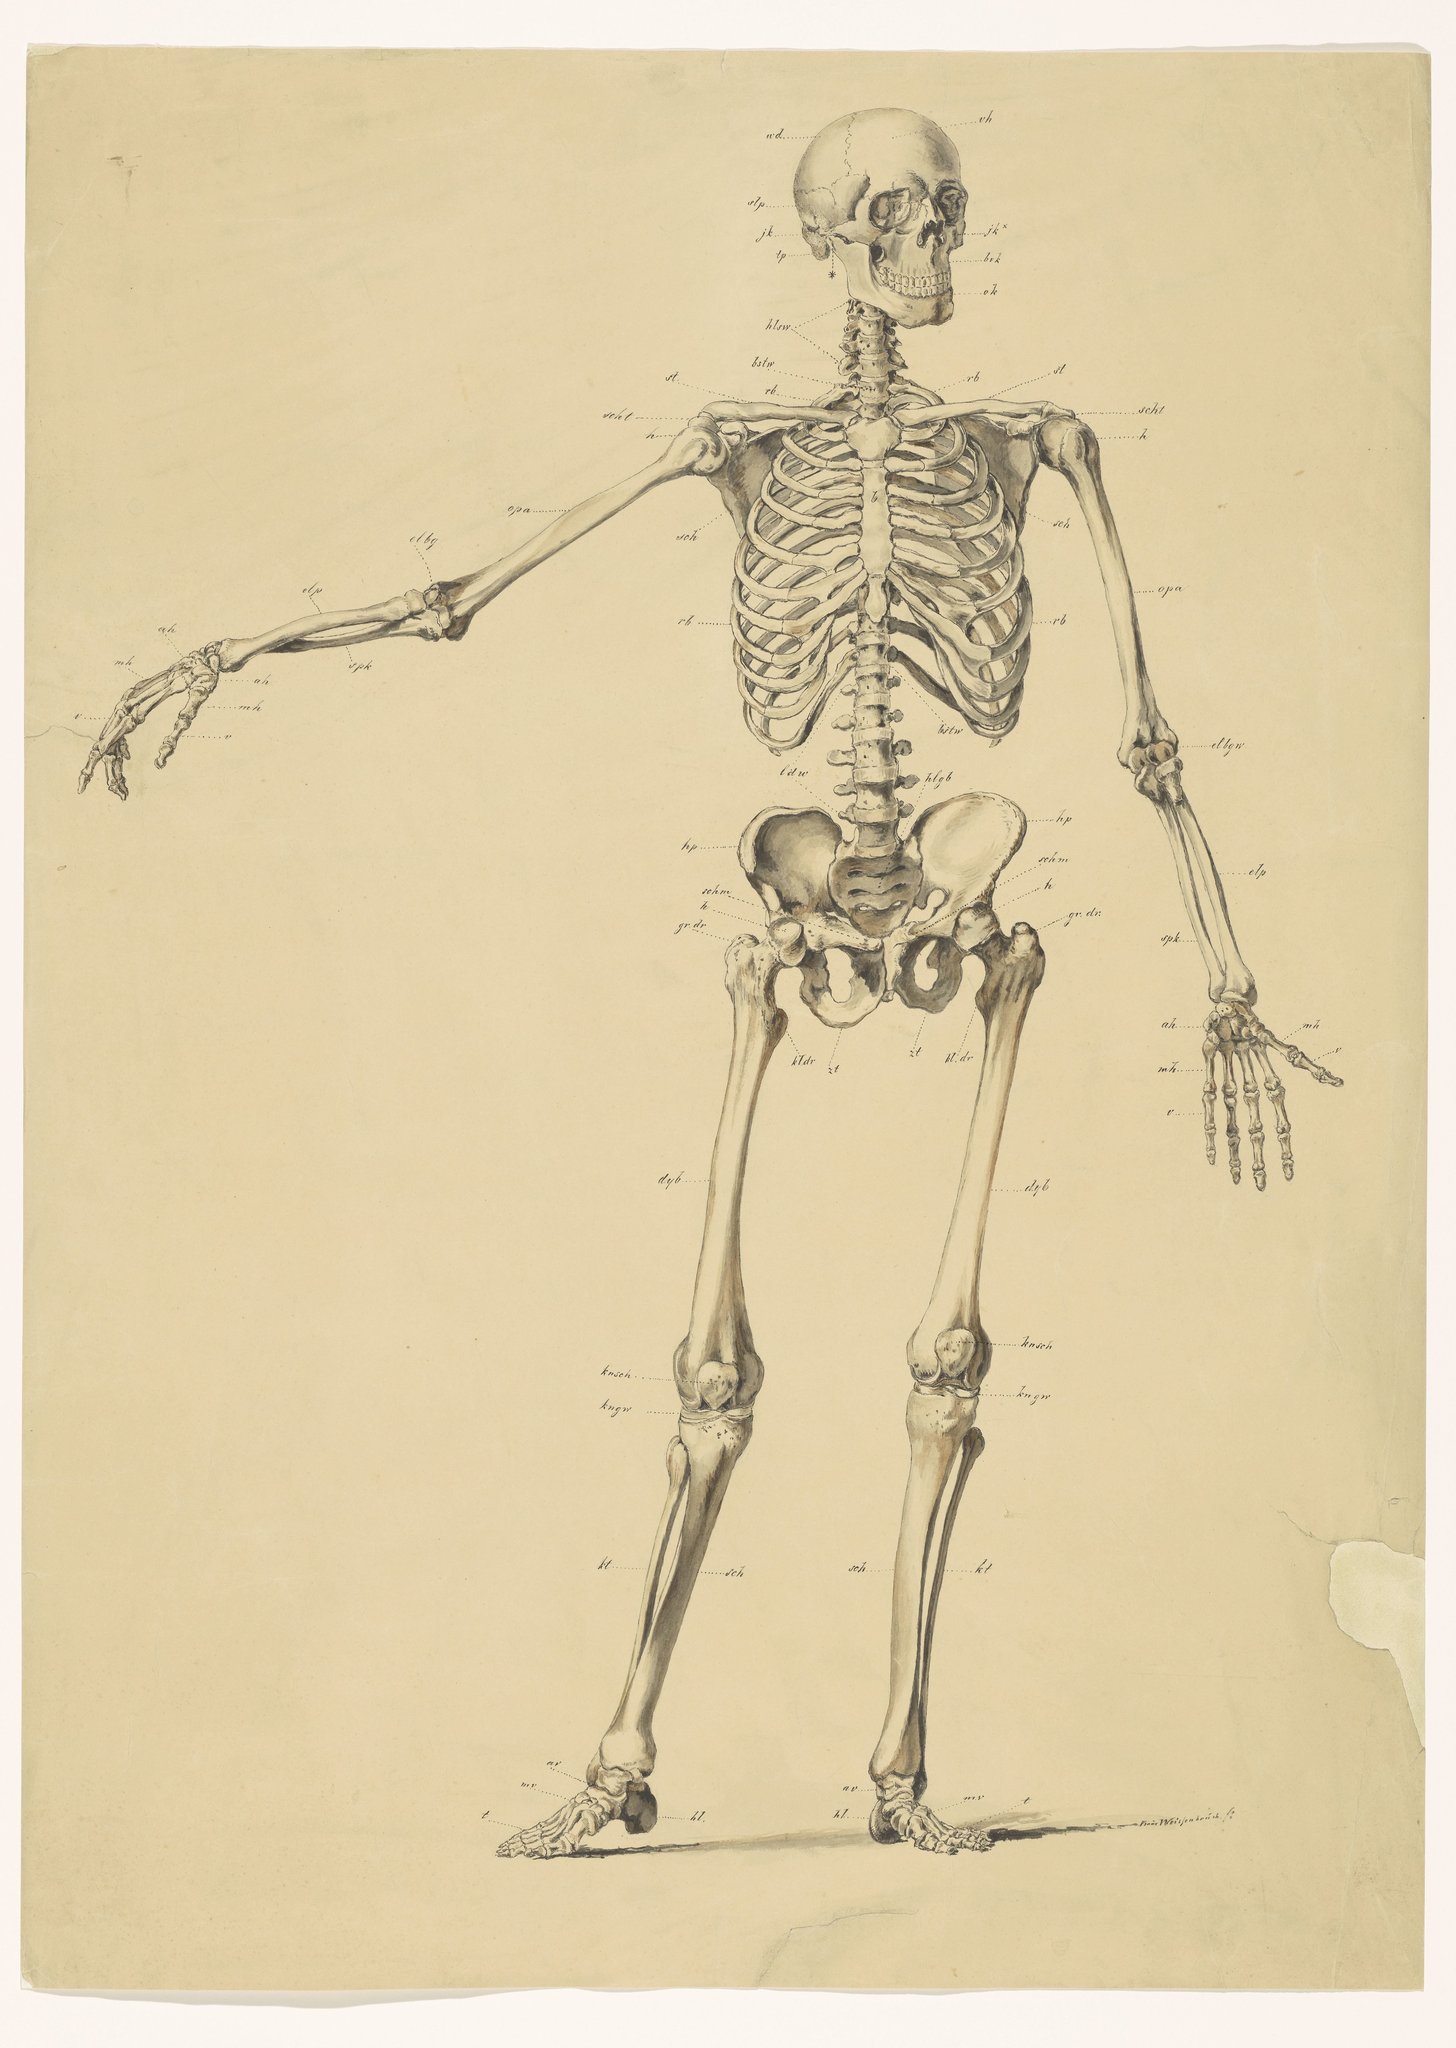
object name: drawing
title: Menselijk geraamte, met notities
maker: isaac weissenbruch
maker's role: print maker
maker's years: 1826-1912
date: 1836-1912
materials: ink, paper, pencil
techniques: brush, pen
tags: (human) skeleton, anatomical model of the skeletal system